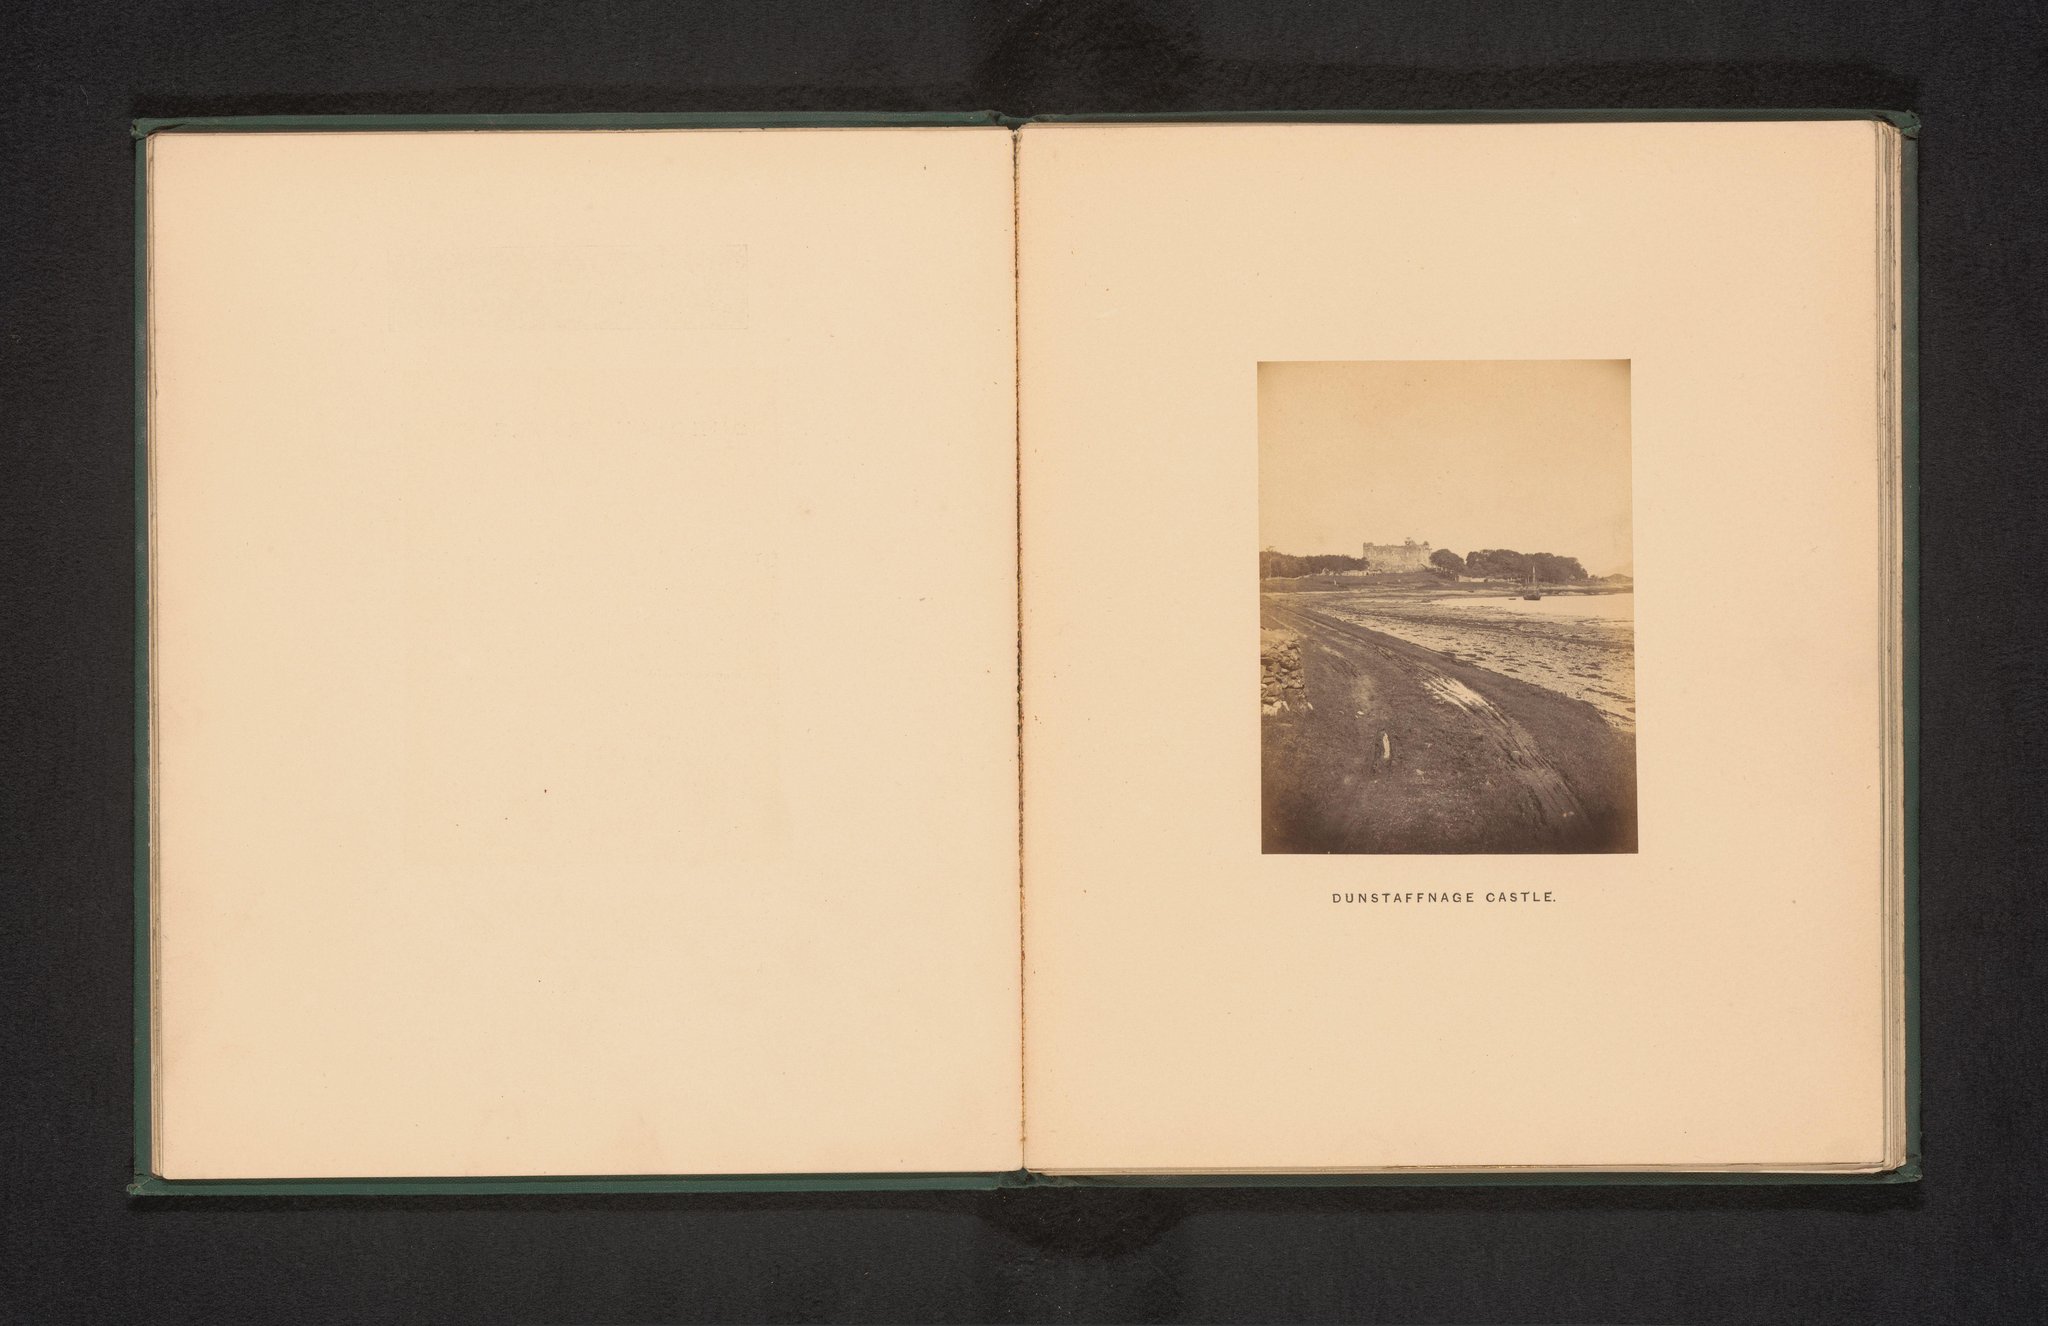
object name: page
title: Gezicht op Dunstaffnage Castle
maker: Anonymous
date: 1862-1867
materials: photographic support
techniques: albumen print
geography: oban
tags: castle, landscapes with waters, waterscapes, seascapes (in the temperate zone), landscape with tower or castle